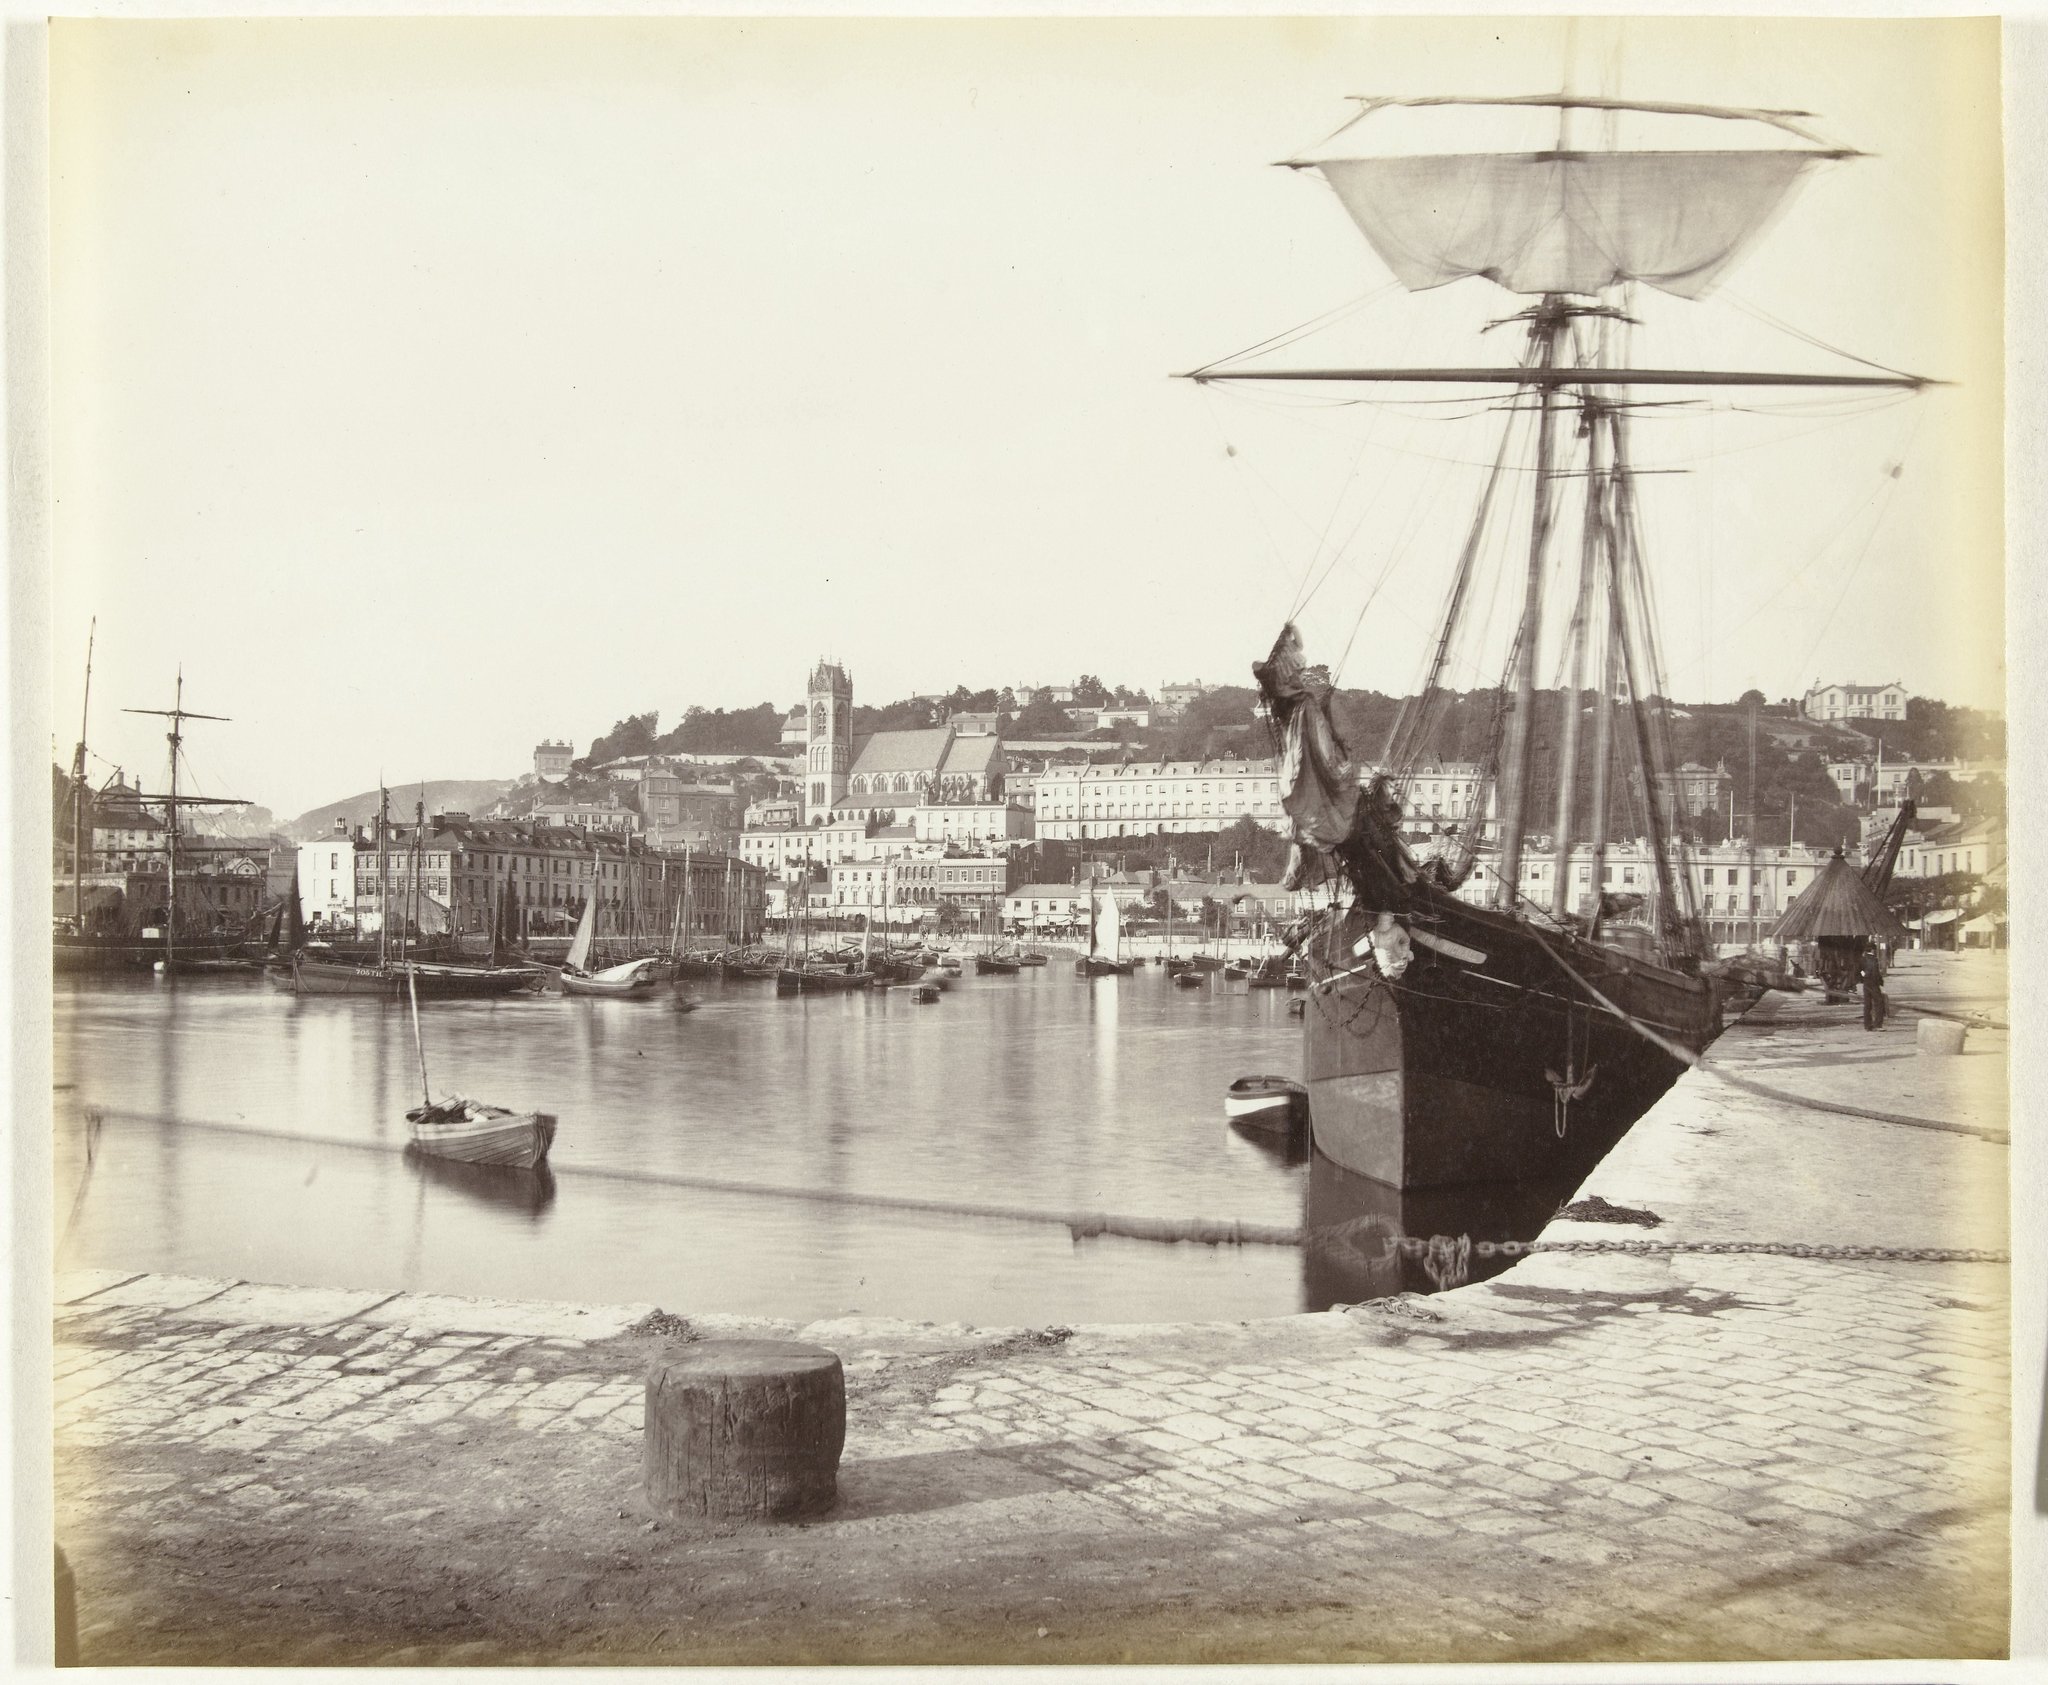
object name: photograph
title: Haven van Torquay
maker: carl frederick musans norman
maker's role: publisher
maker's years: 1841-1927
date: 1880-1905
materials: paper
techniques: albumen print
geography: great britain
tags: harbour